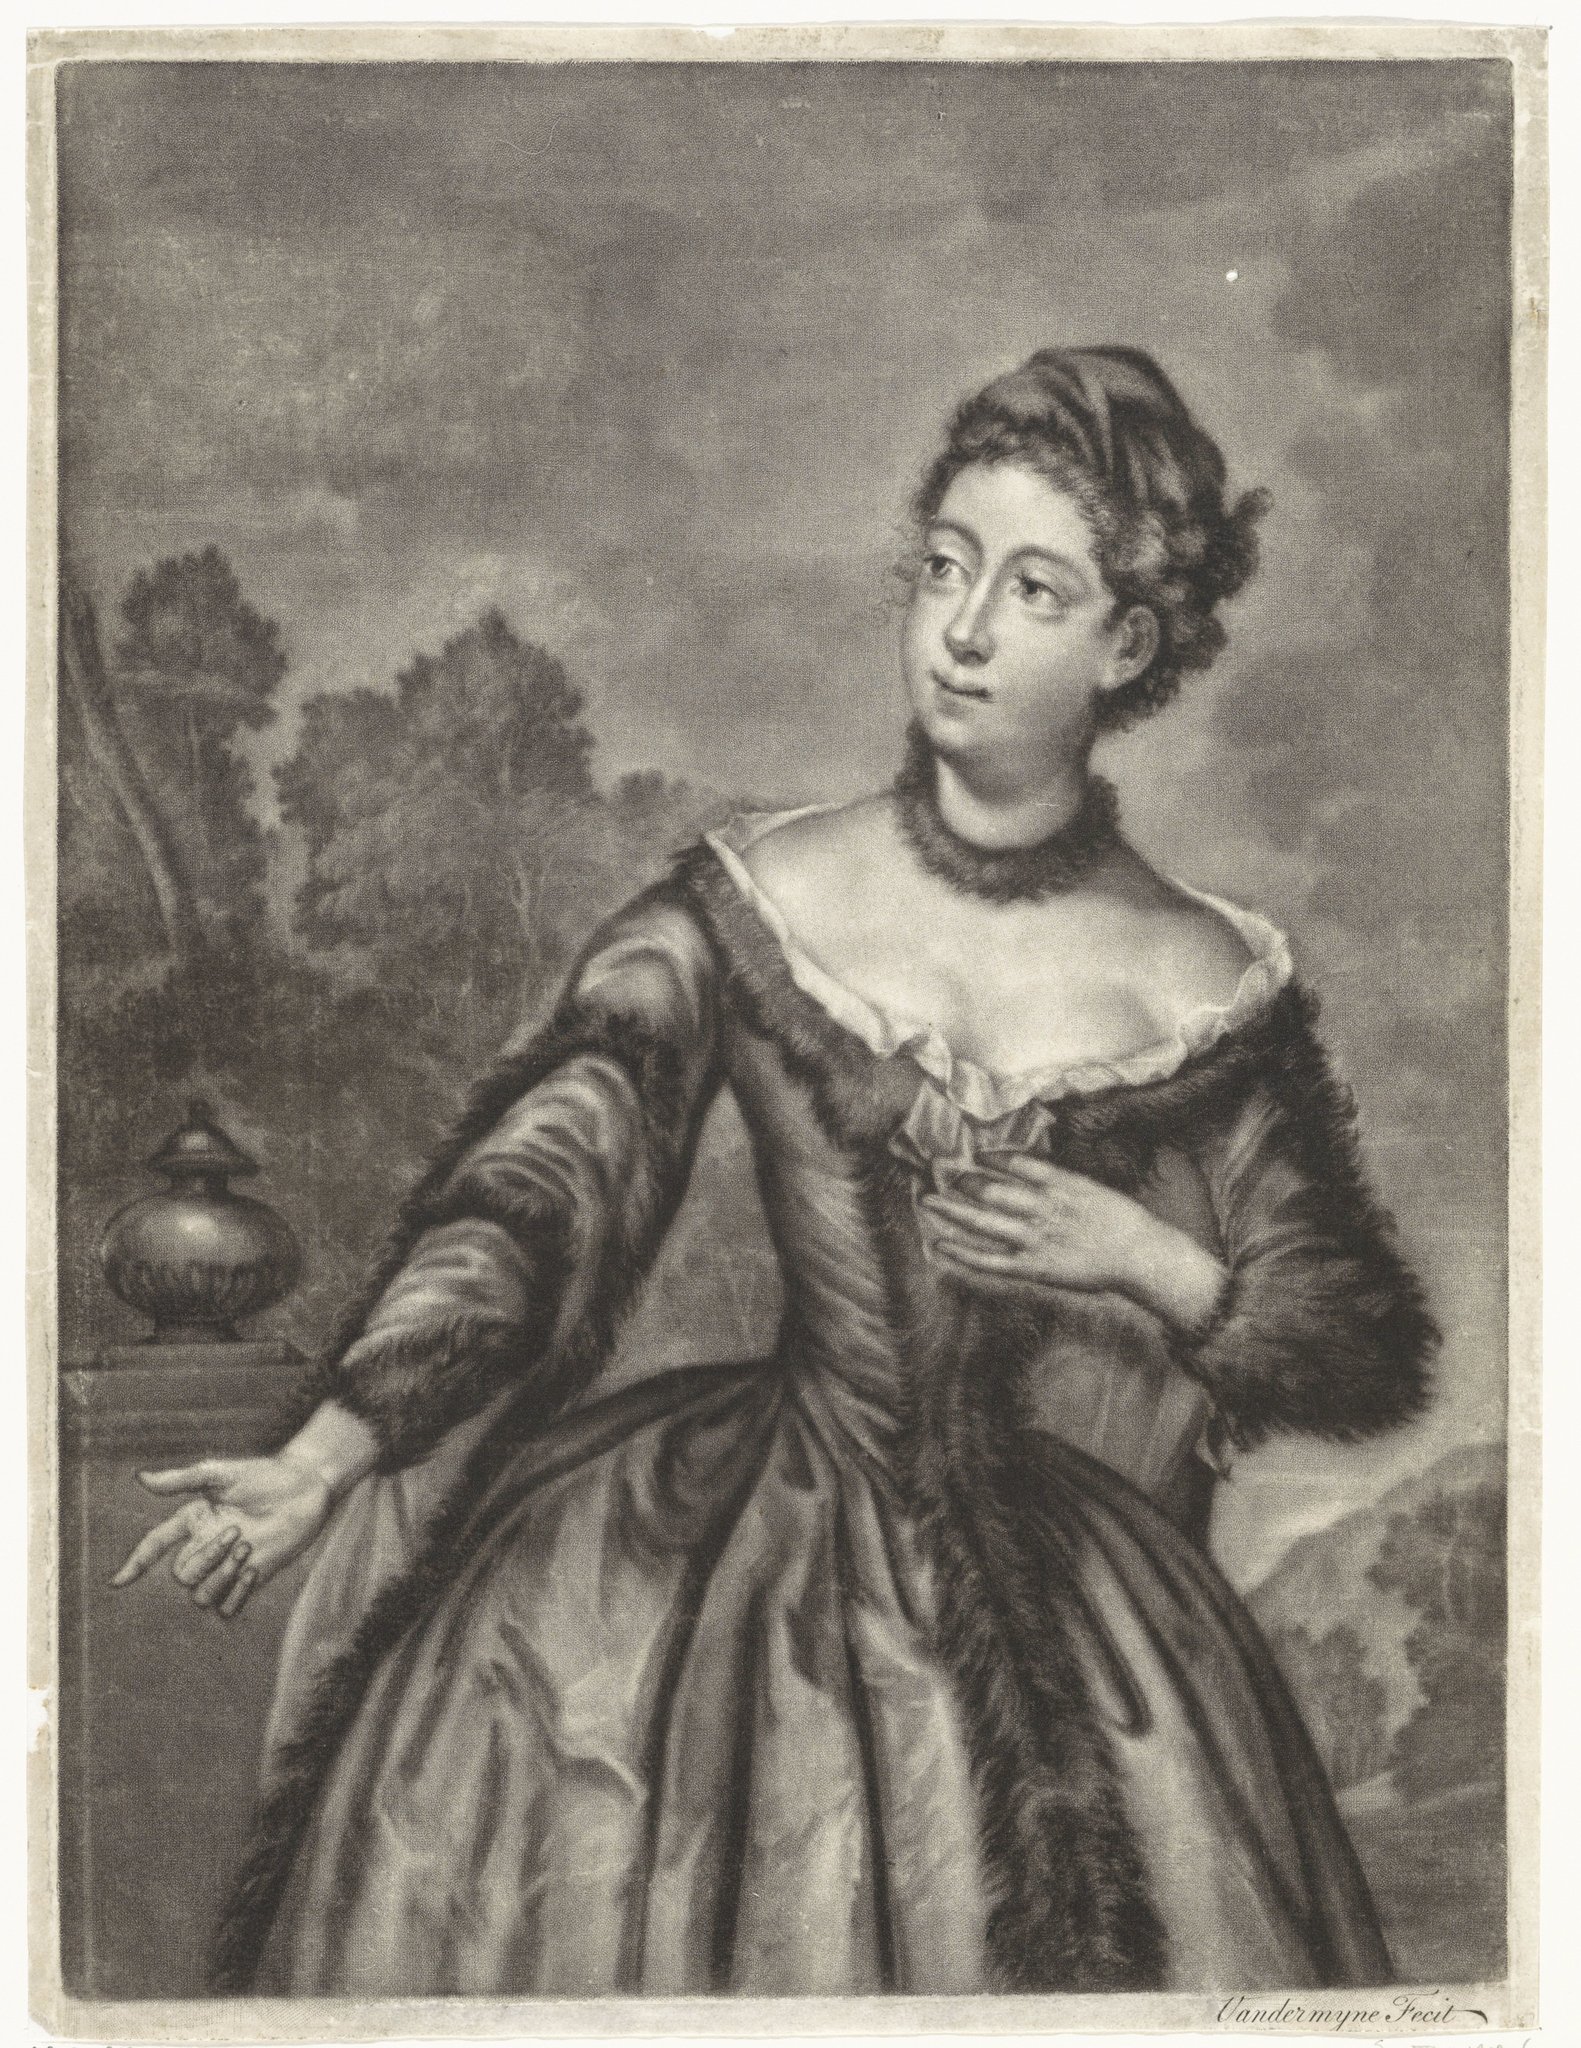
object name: print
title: Portret van een staande vrouw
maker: andreas van der myn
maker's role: print maker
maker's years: 1714-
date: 1724-1800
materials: paper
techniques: engraving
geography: england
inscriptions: collector's mark: Lugt 2228